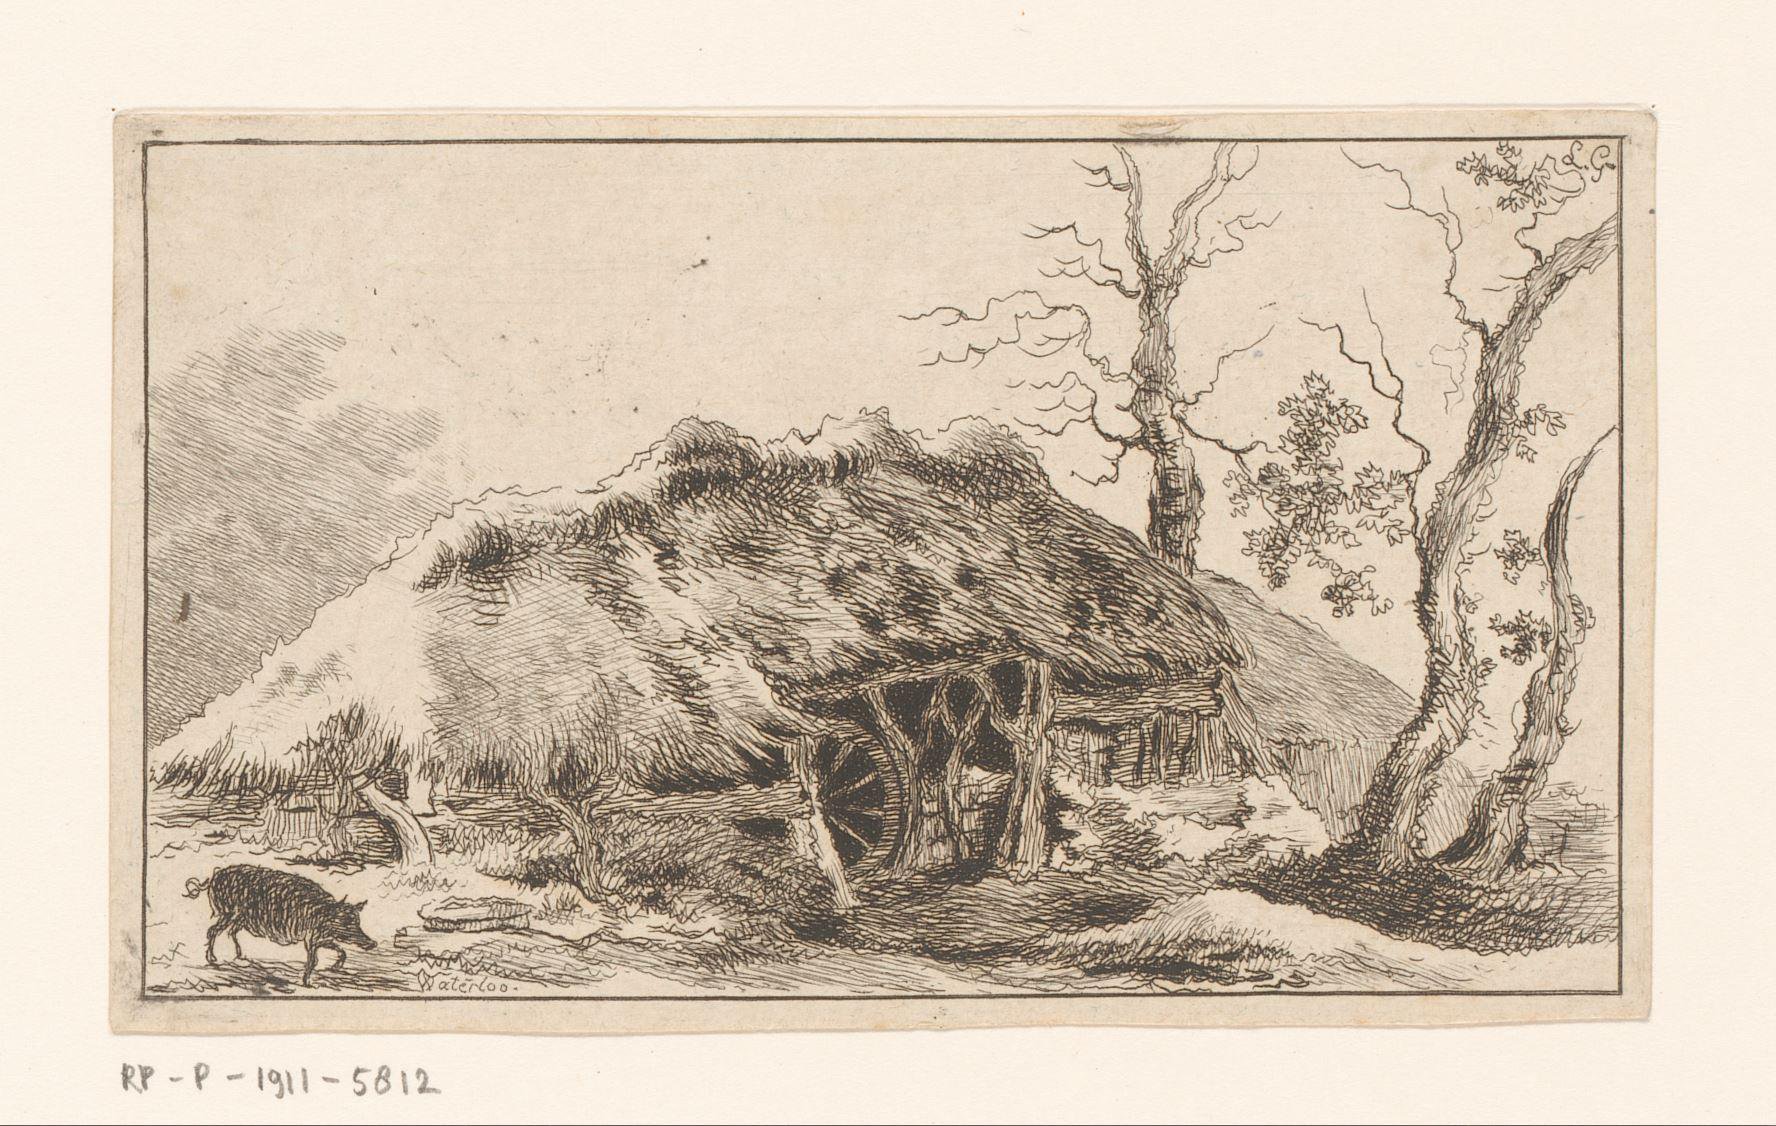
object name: print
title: Boerenhuis met varken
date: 1764-1834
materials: paper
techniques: etching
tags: pig, farm or solitary house in landscape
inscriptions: collector's mark: Lugt 2228